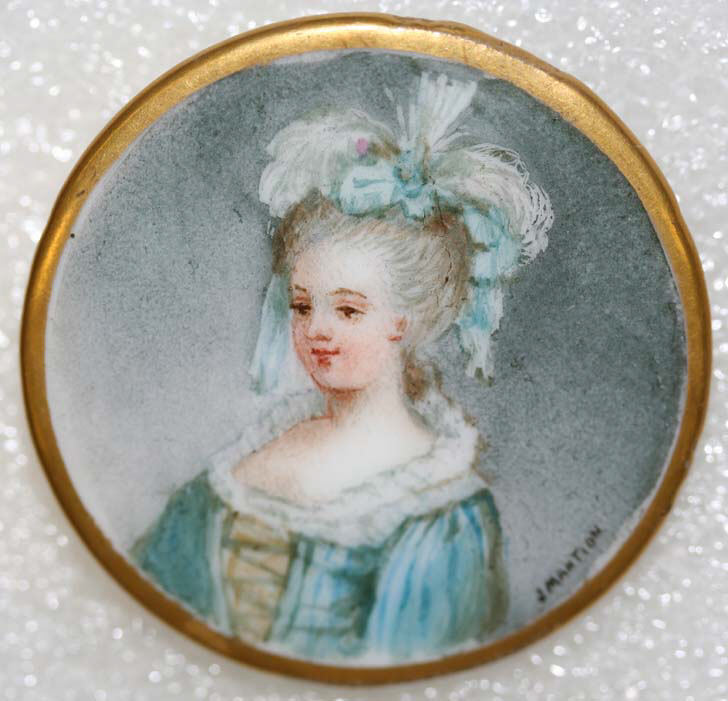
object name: button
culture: british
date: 1880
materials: porcelain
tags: portraits,women